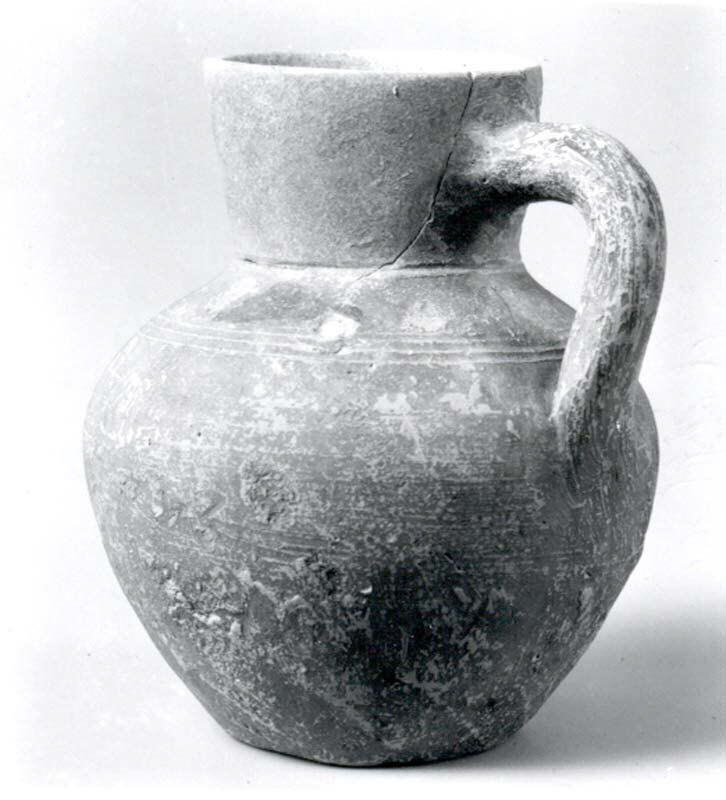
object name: jug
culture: sasanian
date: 201-700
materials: ceramic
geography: iran